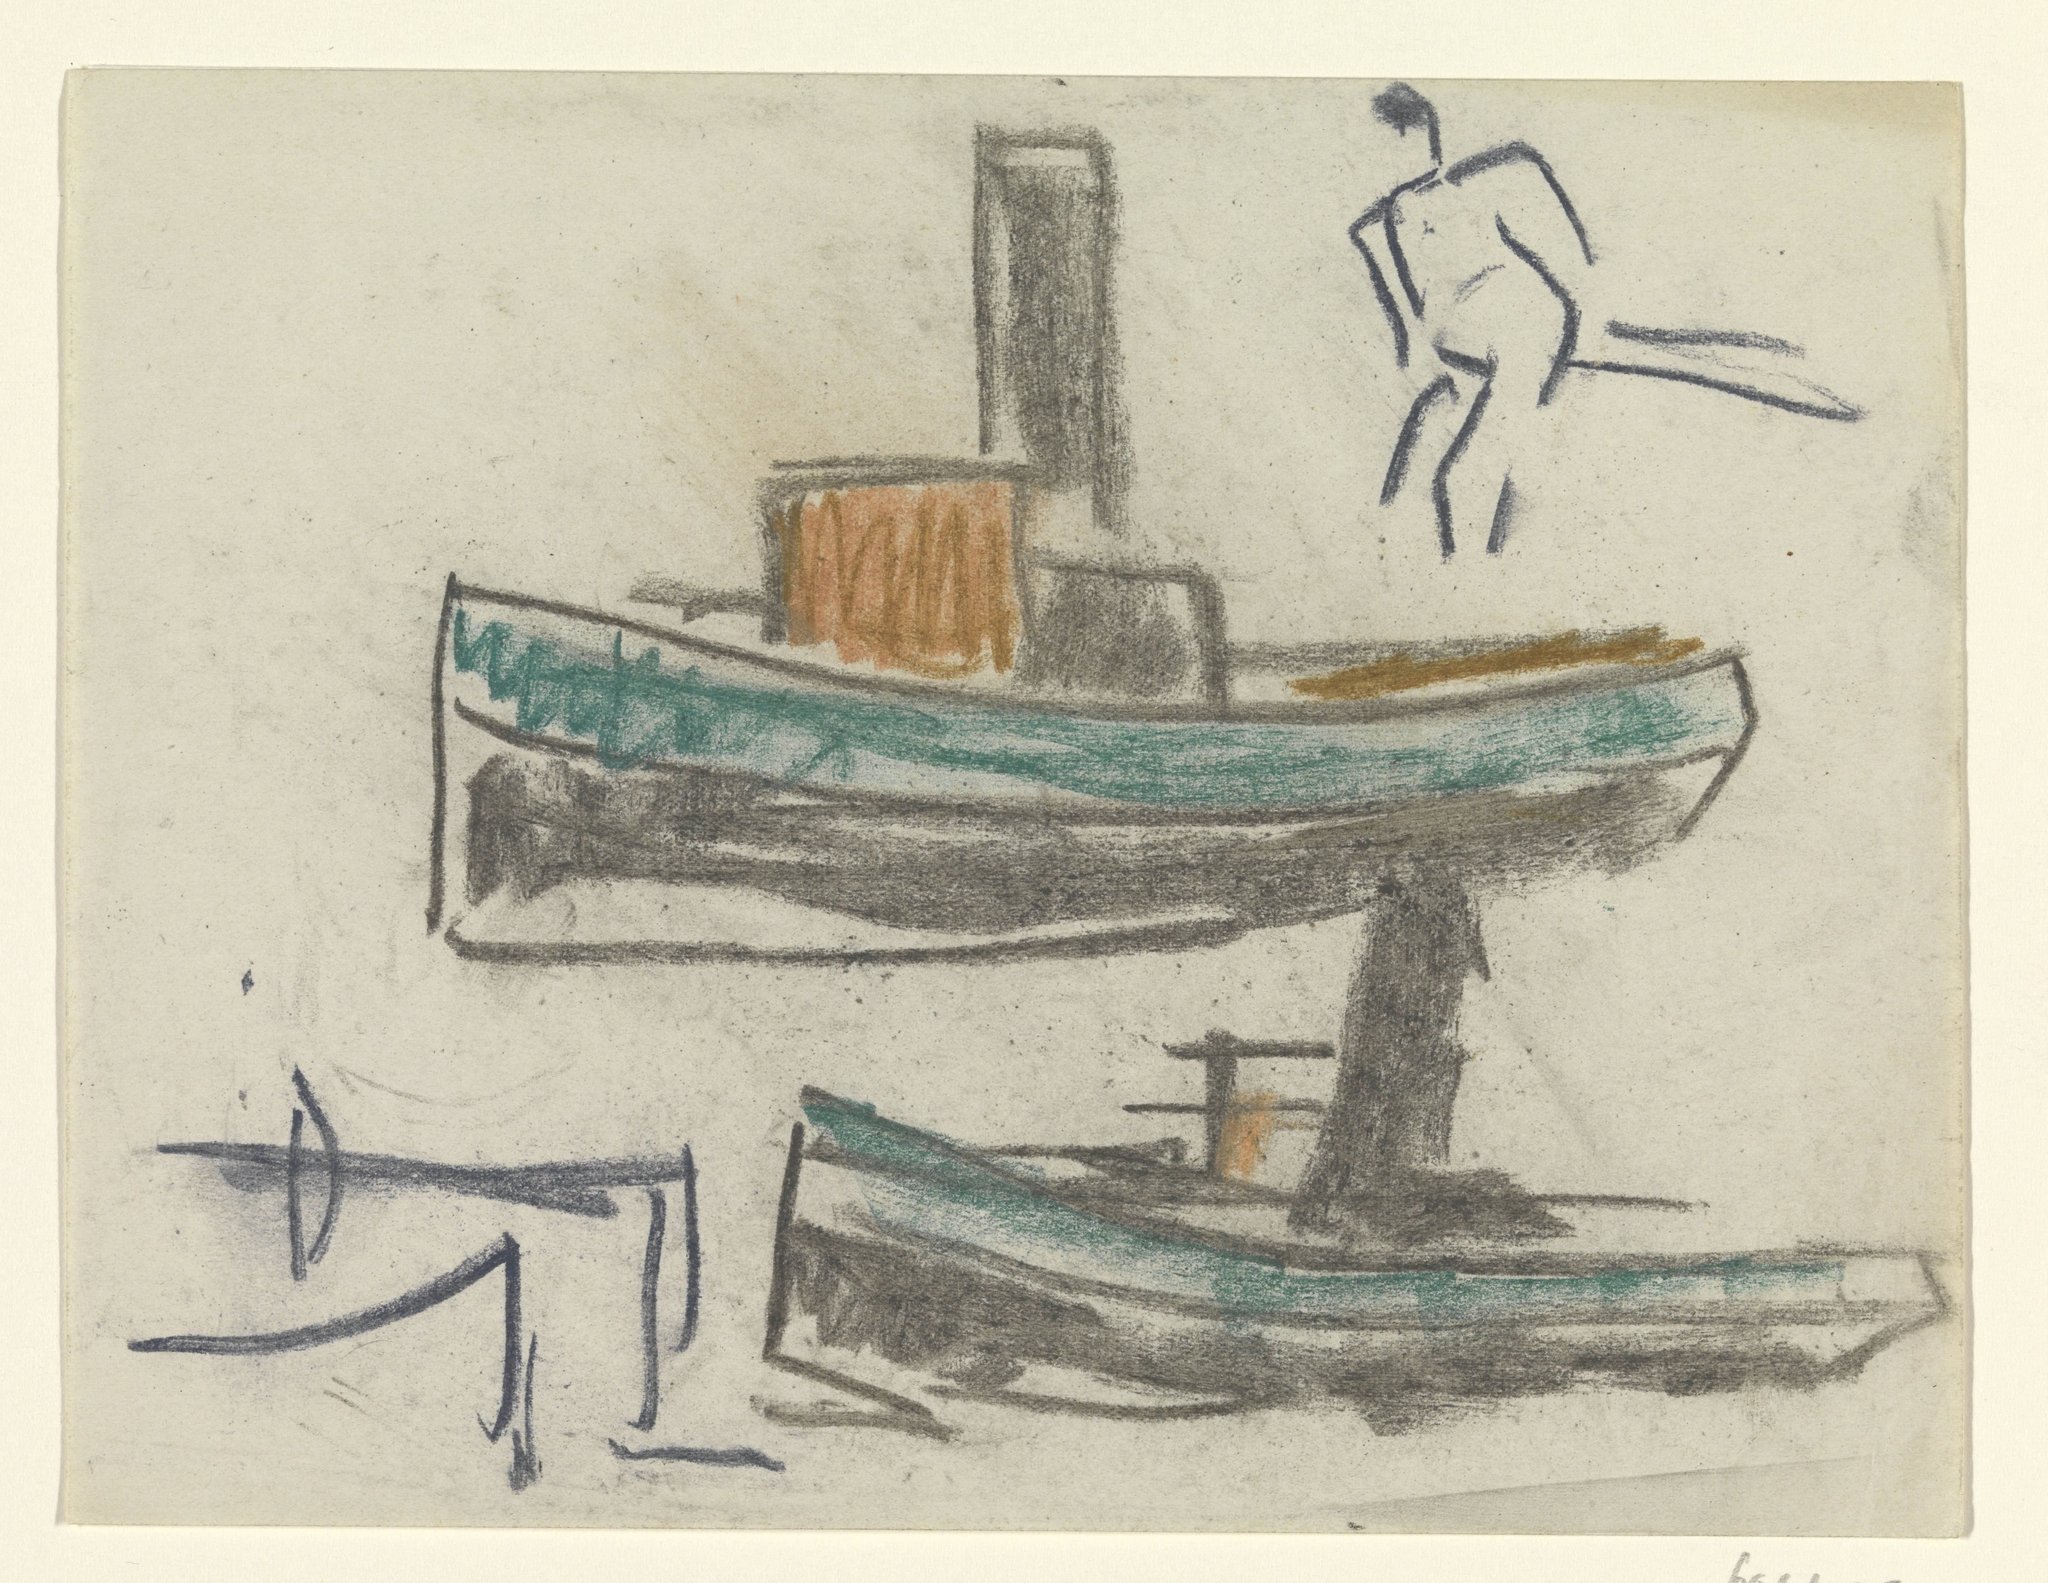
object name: drawing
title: Twee schepen en een figuur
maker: leo gestel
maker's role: draughtsman, print maker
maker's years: 1881-1941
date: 1891-1941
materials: chalk, paper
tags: standing figure, ships (in general)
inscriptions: collector's mark: Lugt 2228